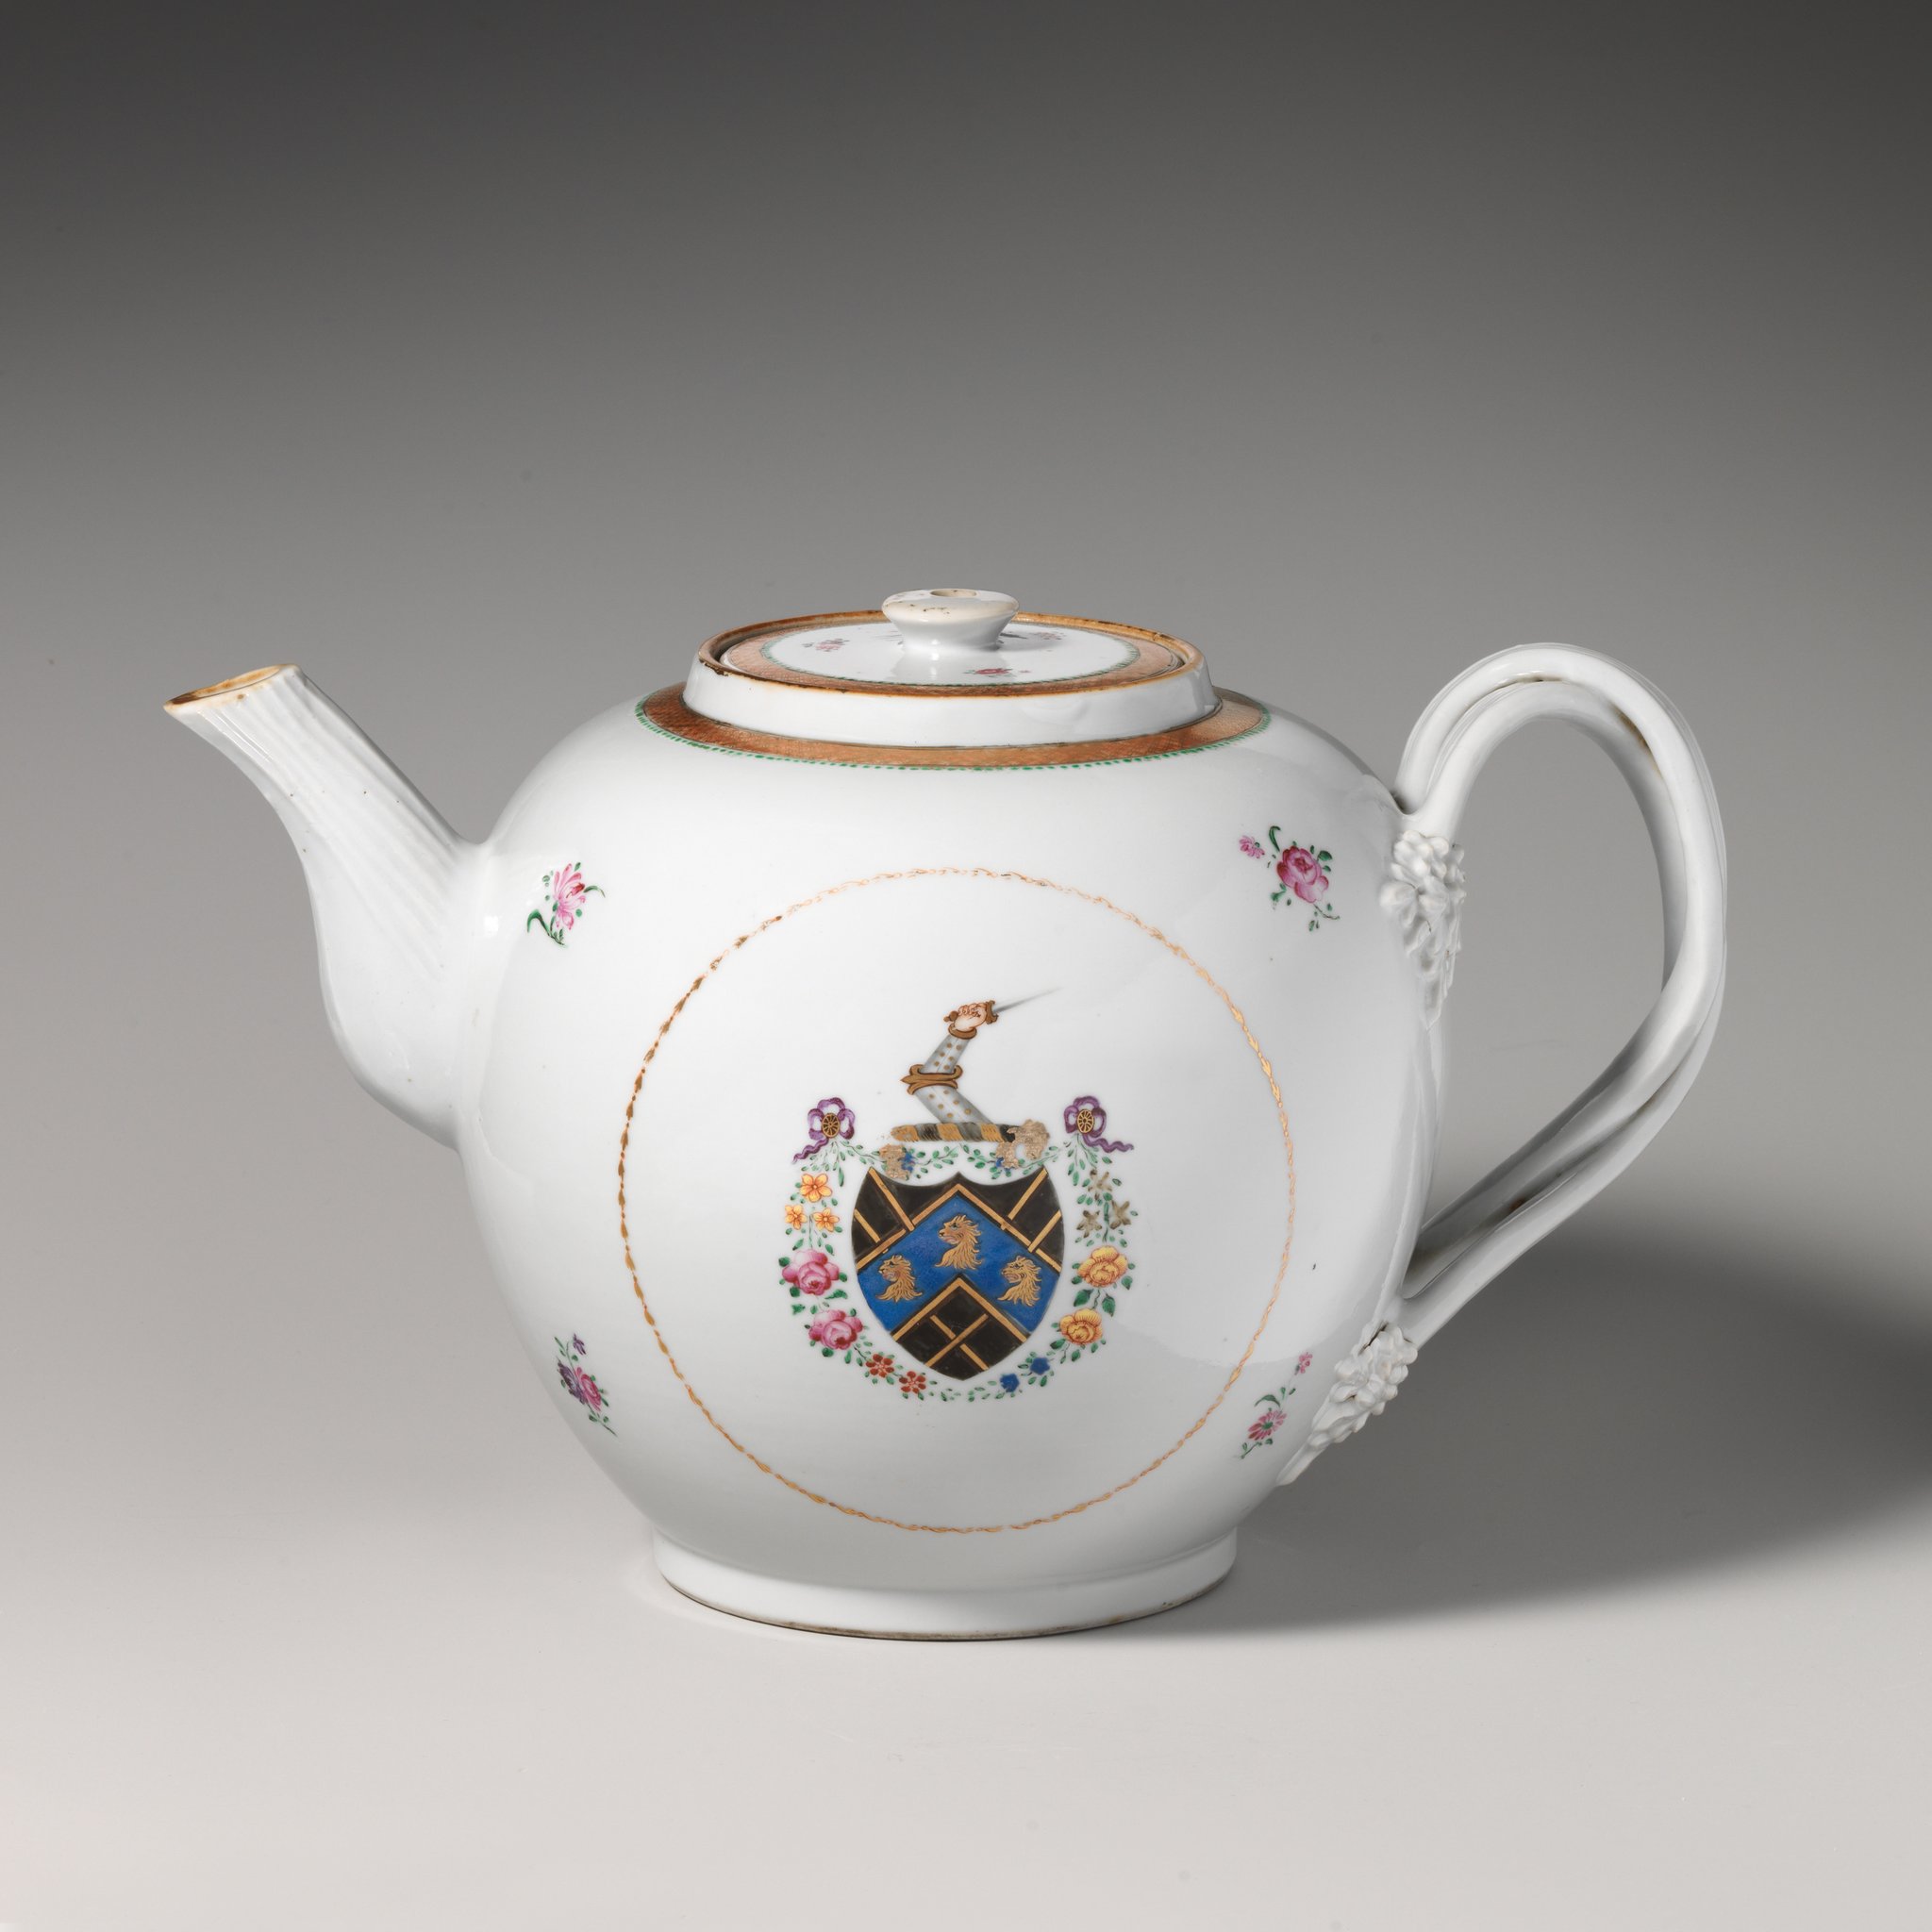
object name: teapot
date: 1790-1800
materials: hard paste porcelain